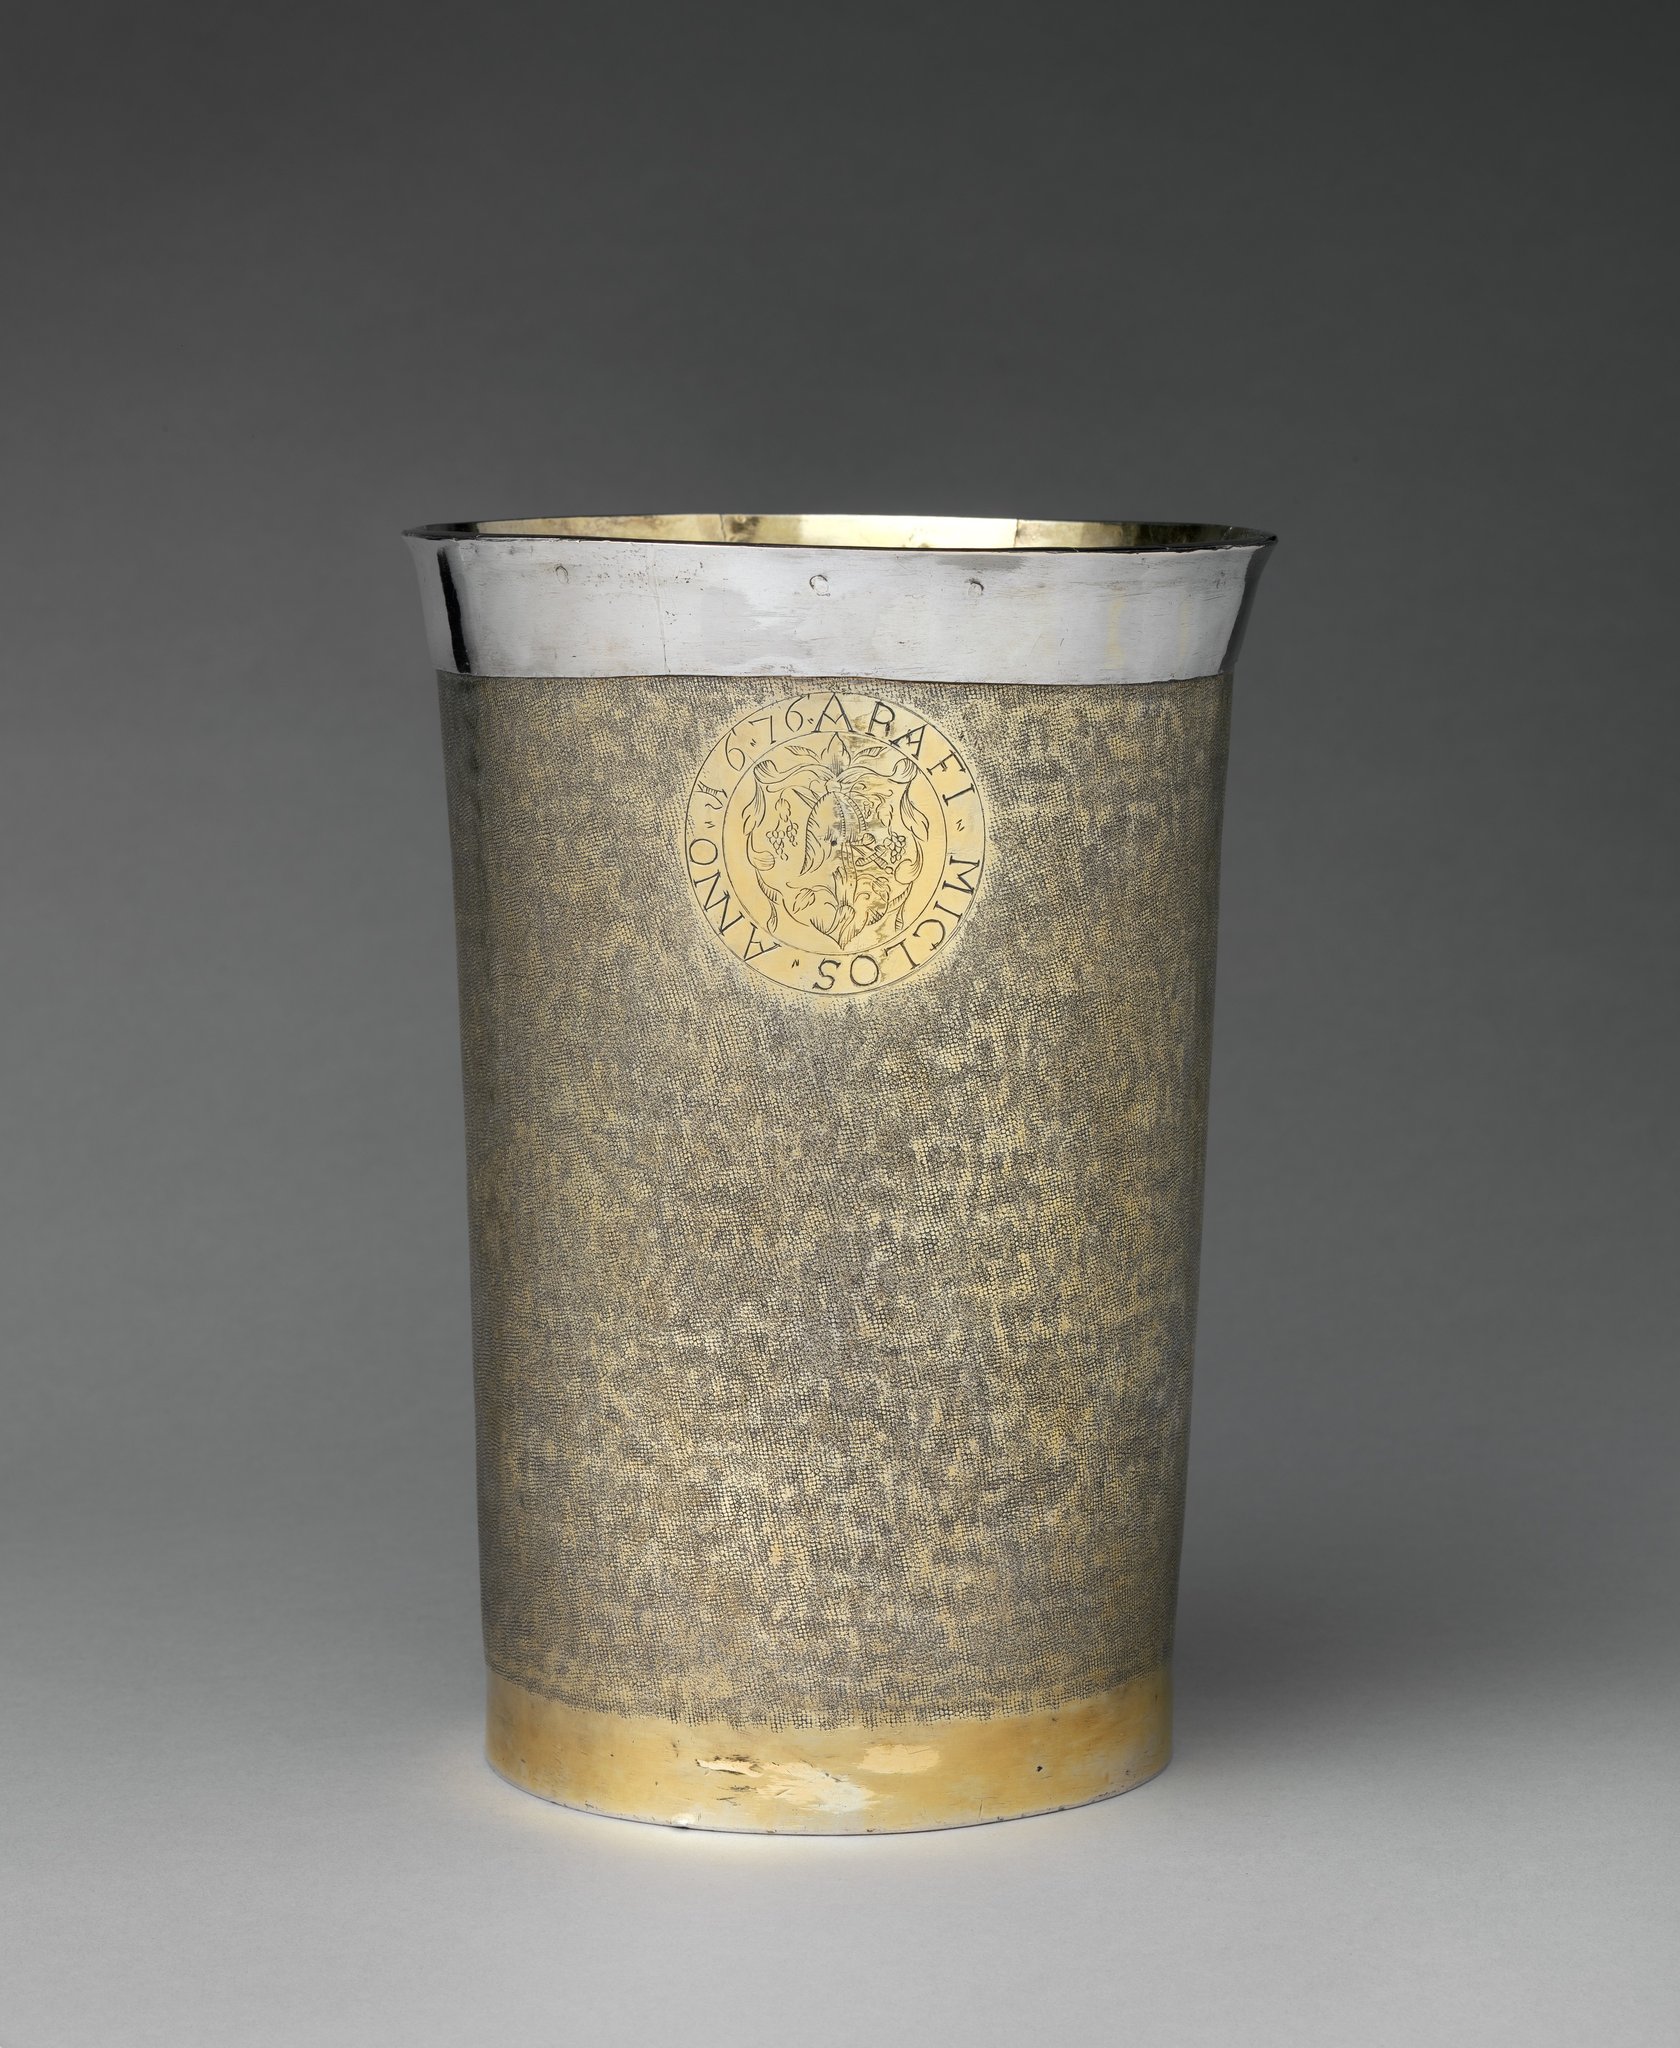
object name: beaker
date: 1676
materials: silver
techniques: gilding